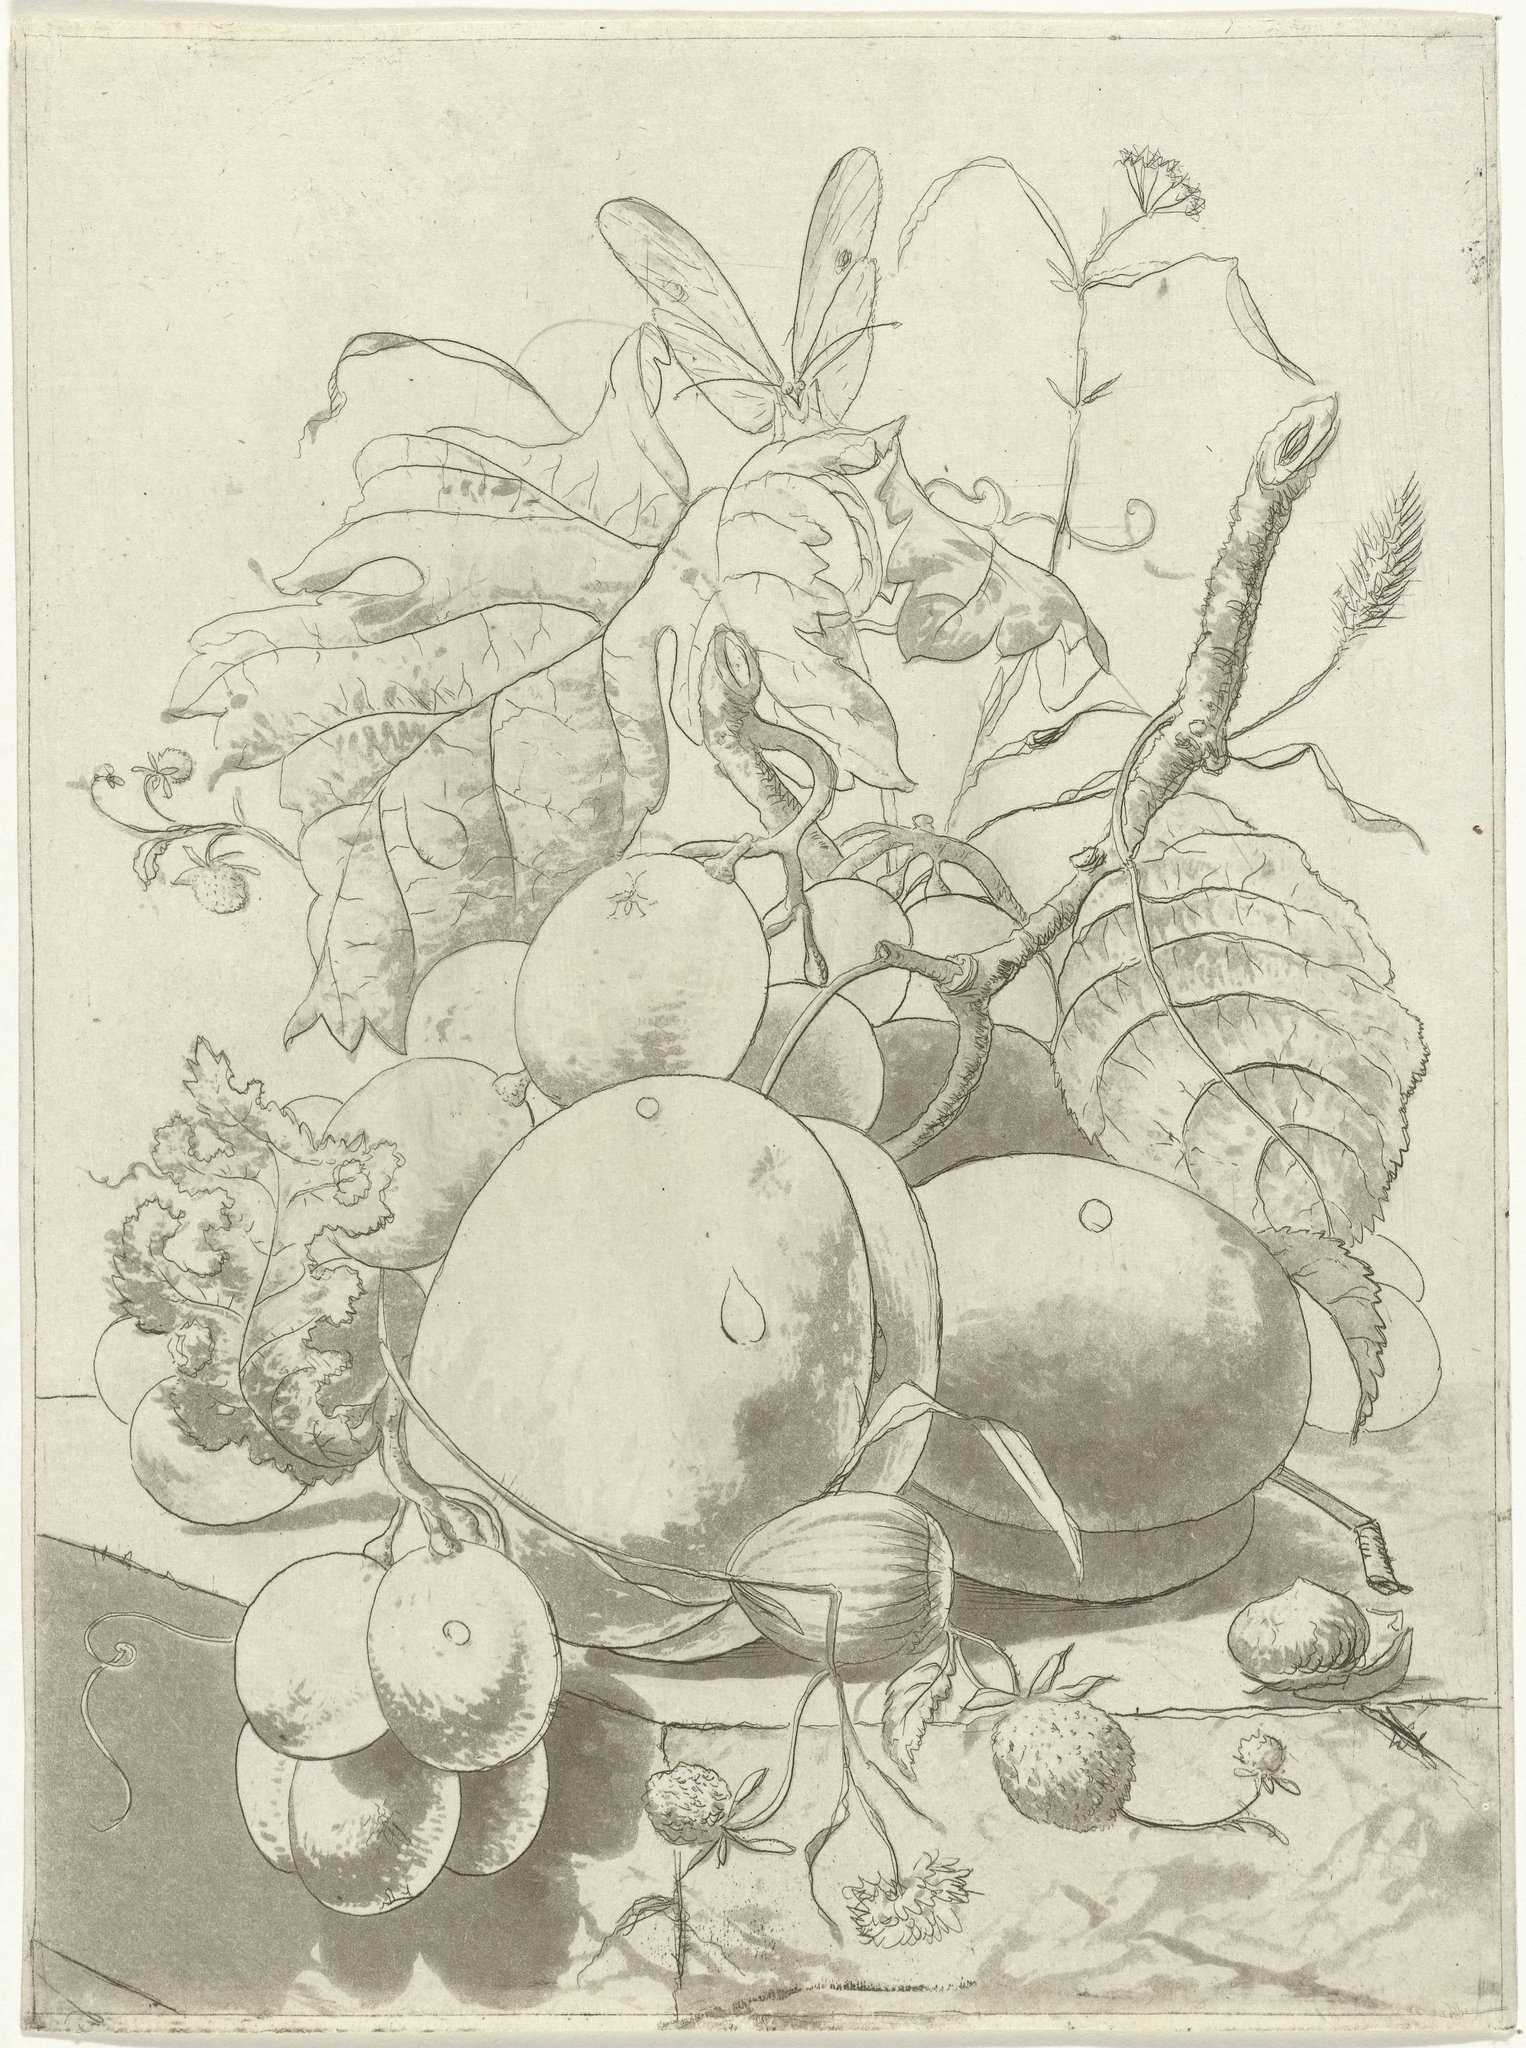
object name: print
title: Vruchten en een tak met een vlinder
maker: hermanus fock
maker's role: conservator, draughtsman, painter, print maker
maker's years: 1766-1822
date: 1781-1822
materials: paper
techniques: aquatint, etching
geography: amsterdam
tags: fruits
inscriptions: collector's mark: Lugt 2228